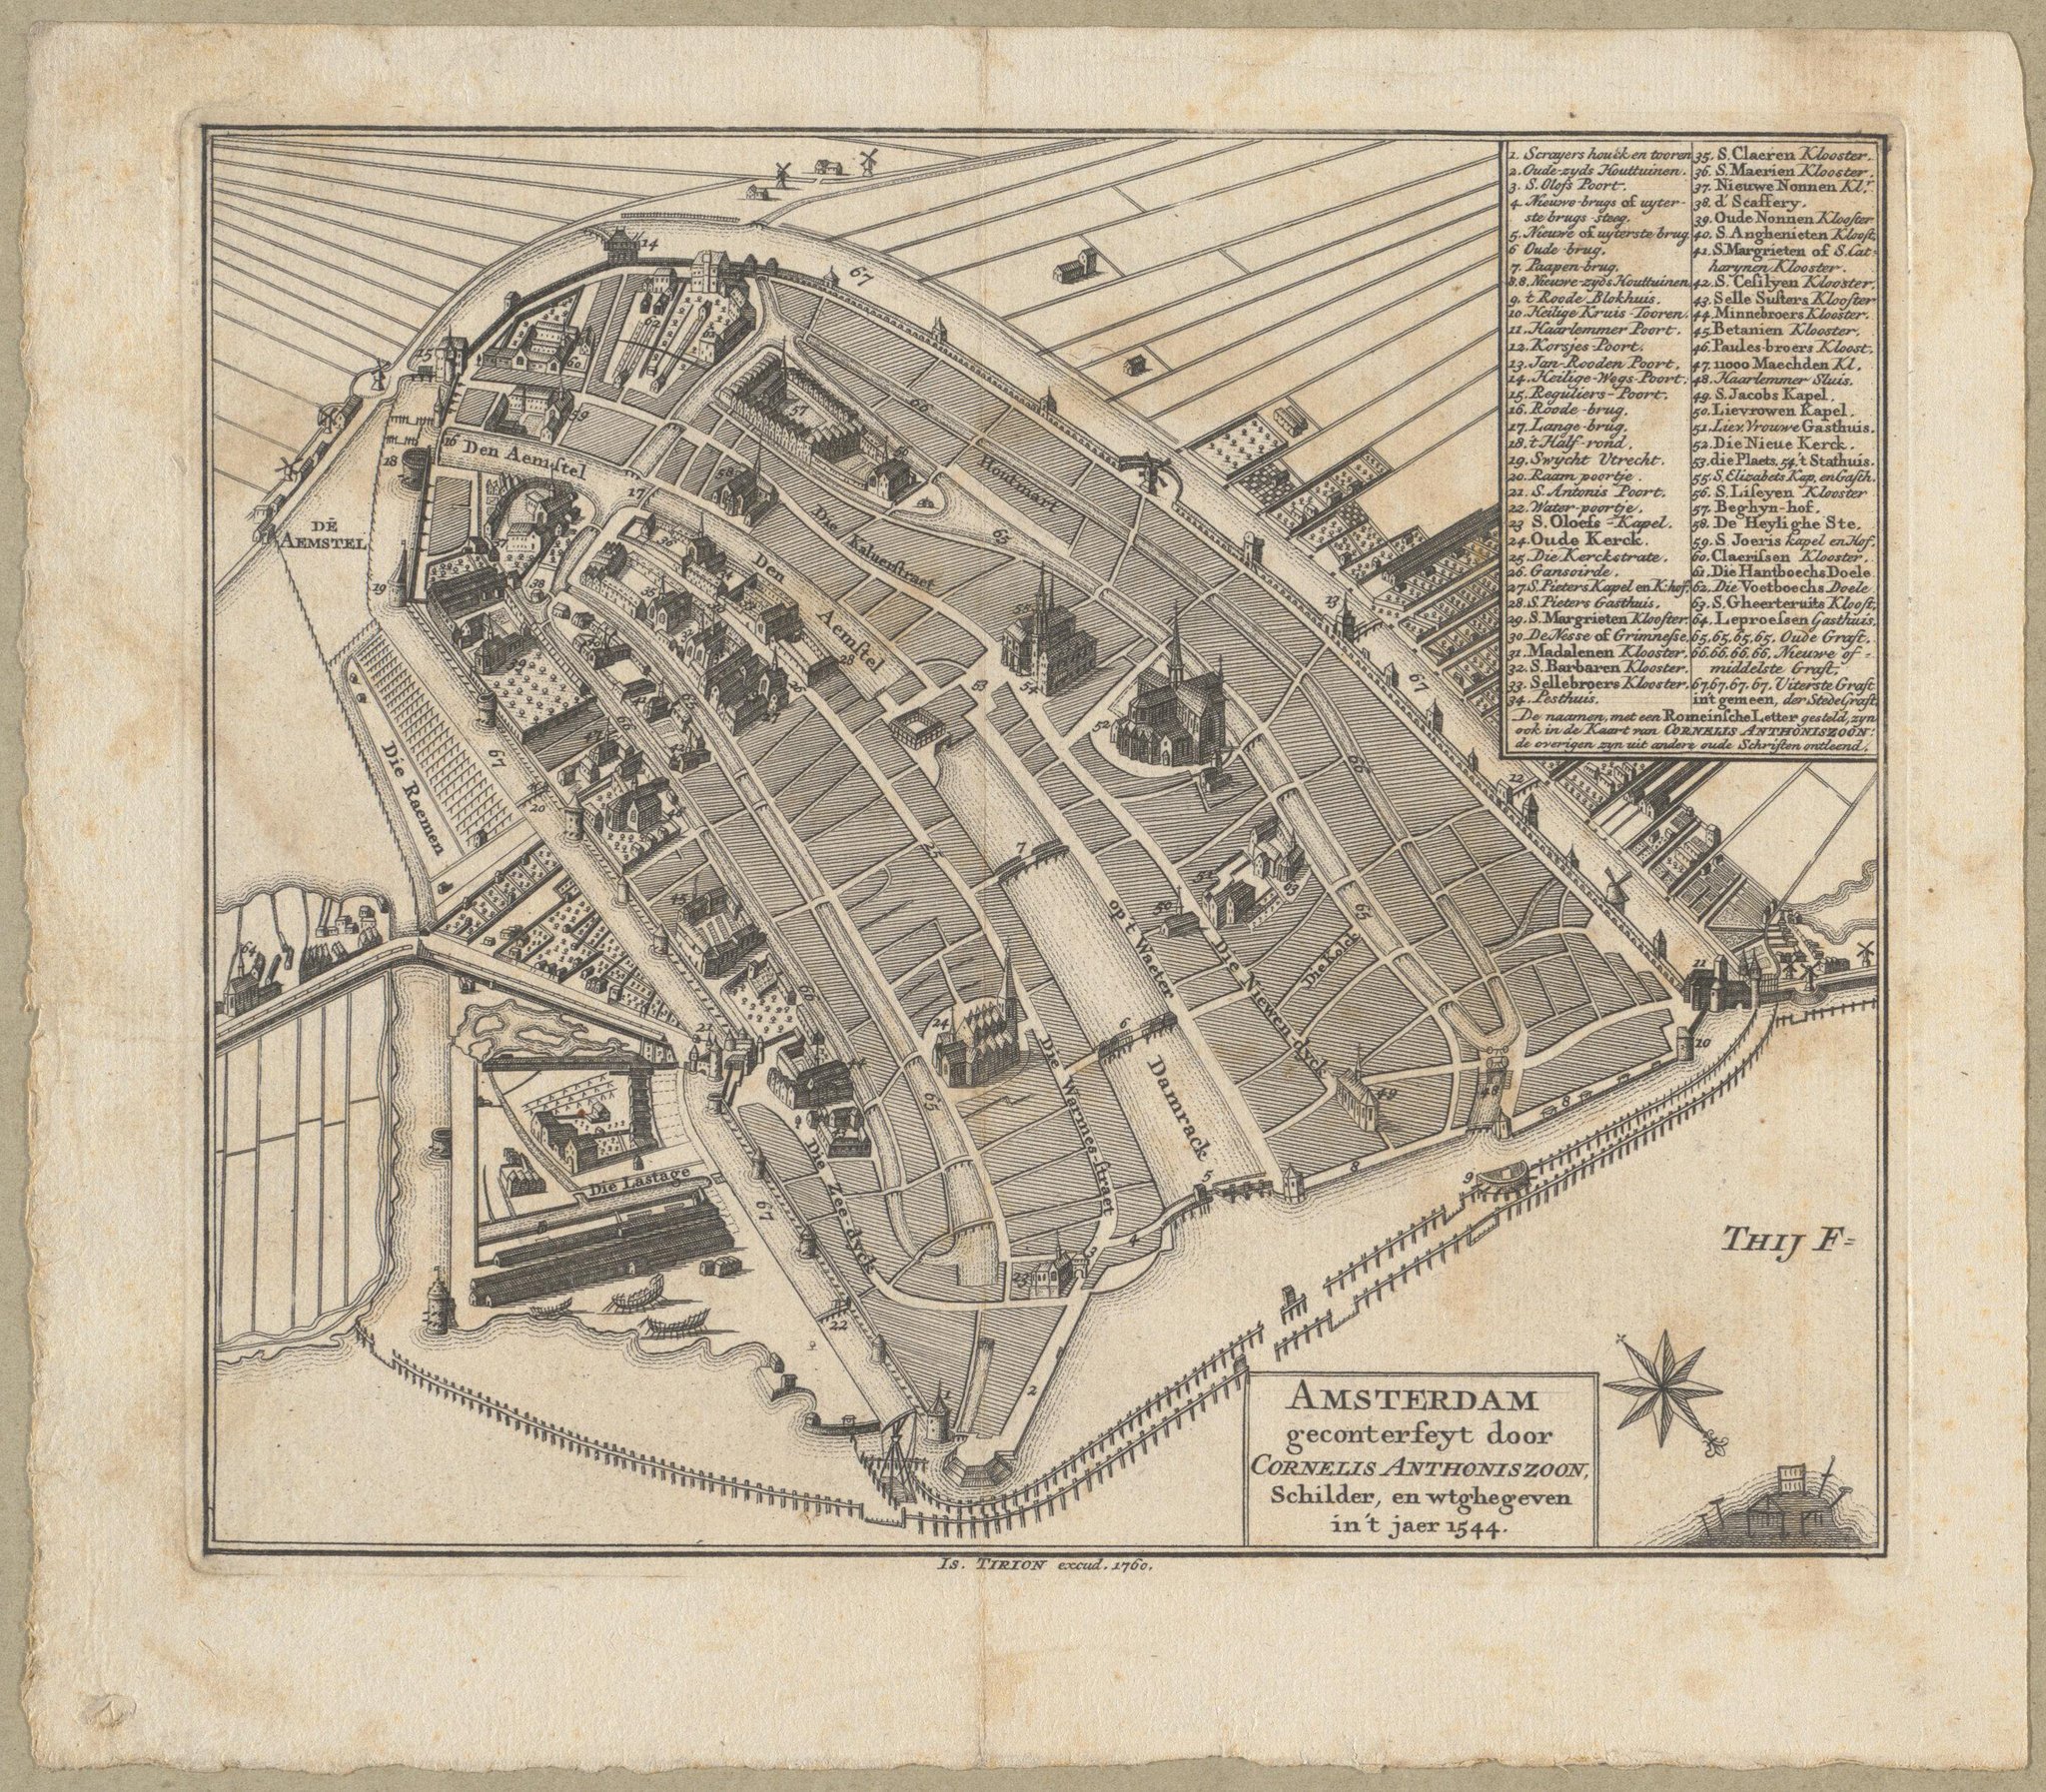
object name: print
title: Plattegrond van Amsterdam, 1544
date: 1760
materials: paper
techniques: engraving, etching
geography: amsterdam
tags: maps of cities, amsterdam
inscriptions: collector's mark: Lugt 1641b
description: Prent mogelijk uit: Wagenaar, Jan. Amsterdam, in zyne opkomst, aanwas, geschiedenissen (…). Amsterdam: Isaak Tirion, 1760, dl. 1.